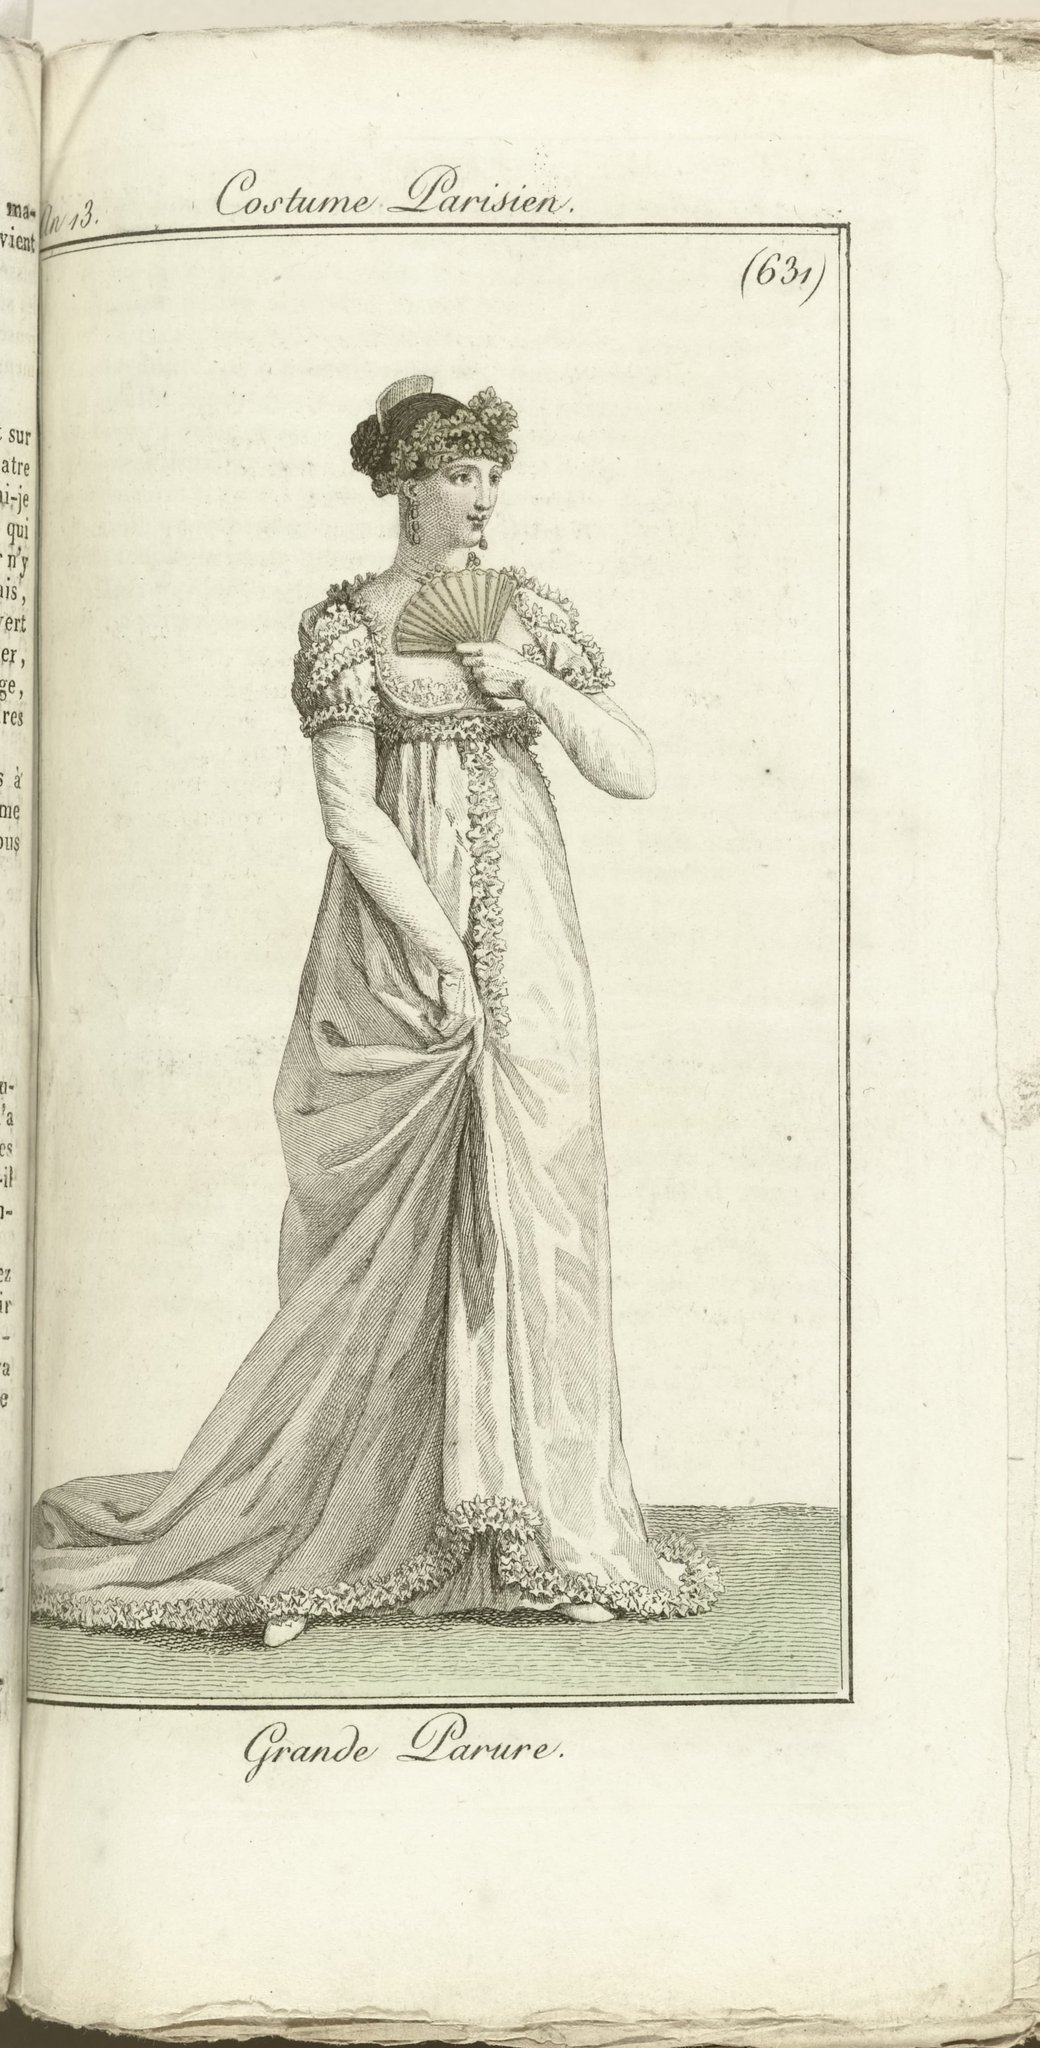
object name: fashion print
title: Journal des Dames et des Modes, Costume Parisien, 1805, An 13 (631) Grande Parure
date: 1805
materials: paper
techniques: engraving, hand coloring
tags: ear-rings (+ women's clothes), dress, gown: court gown or court dress (+ women's clothes), gloves, mittens (long gloves) (+ women's clothes), fashion plates, fan (+ women's clothes), necklace (+ women's clothes)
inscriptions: title: ‘Grande Parure’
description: Dame in 'grande parure": witte japon met sleep versierd met rouches; lange handschoenen, opengeklapte waaier in de hand. Met de andere hand houdt ze haar sleep op. Tiara op het hoofd. Langwerpige oorbellen.